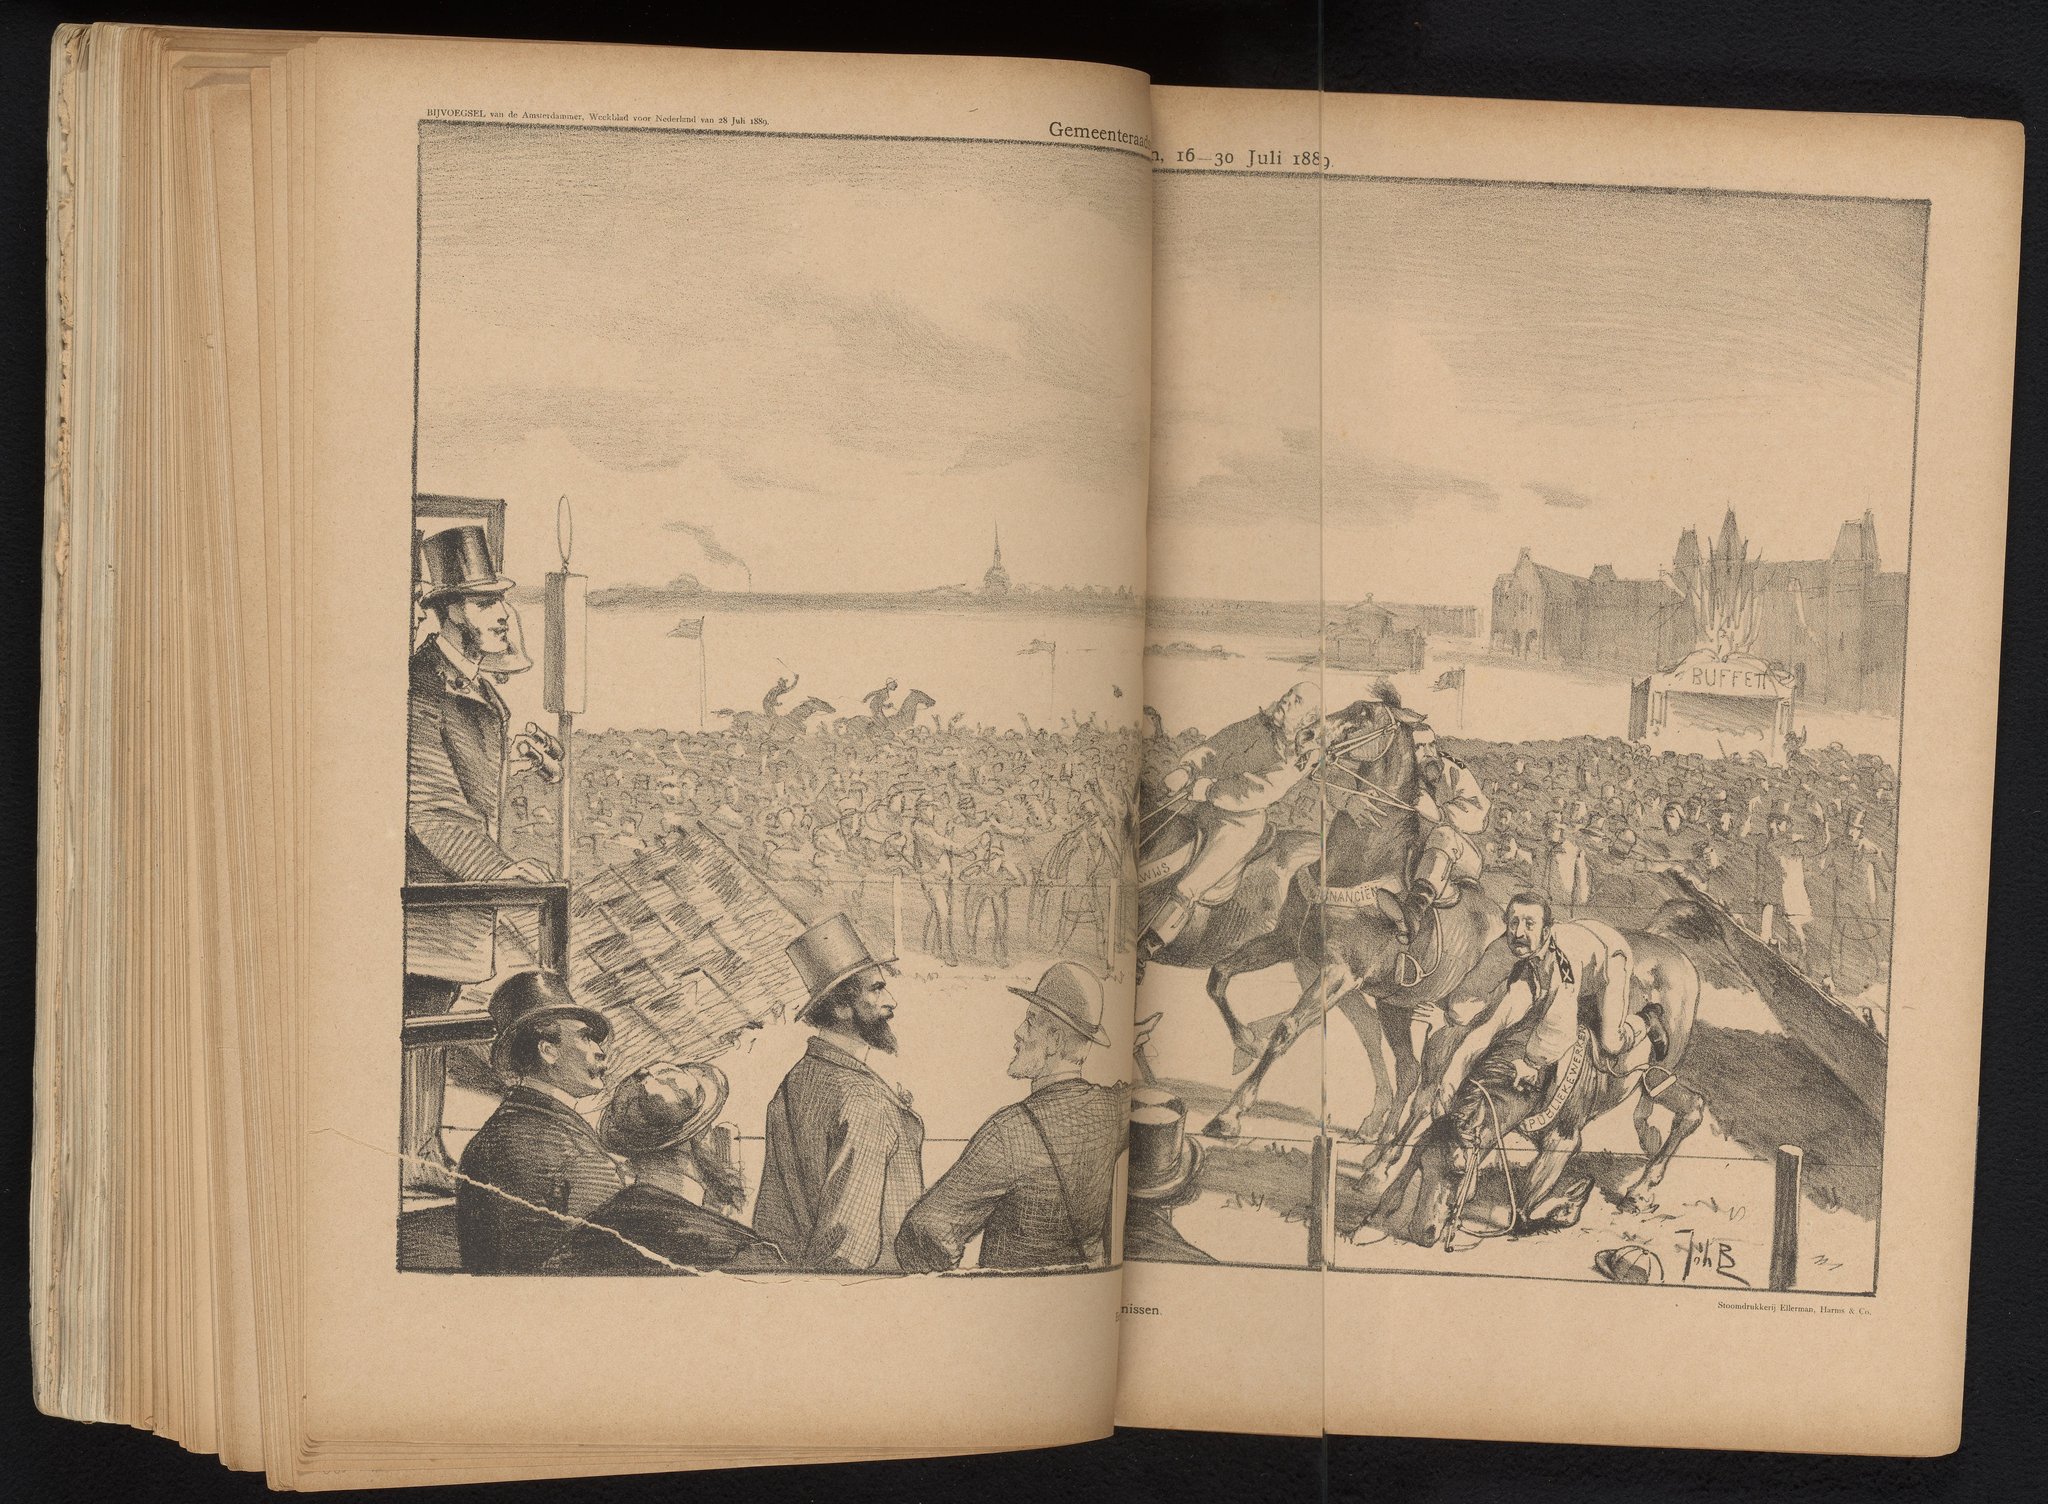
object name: cartoon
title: Gemeenteraadsverkiezingen, 16-30 Juli 1889. Een wedren met hindernissen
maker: johan braakensiek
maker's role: draughtsman, print maker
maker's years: 1858-1940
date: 1889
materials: paper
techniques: lithograph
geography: netherlands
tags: mayor, gijsbert van tienhoven, voting, election, horse-racing, municipal government, political caricatures and satires, amsterdam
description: De Gemeenteraadsverkiezingen van Amsterdam van 16 juli voorgesteld als paardenrenwedstrijd, waarbij de drie kandidaten hun paarden bij de start maar moeilijk in toom kunnen houden. Gesitueerd op het Museumplein, met rechts het Rijksmuseum en met grote groepen opgewonden mensen achter hekken. Op de voorgrond burgemeester Van Tienhoven. Grote voorstelling op twee bladzijden.